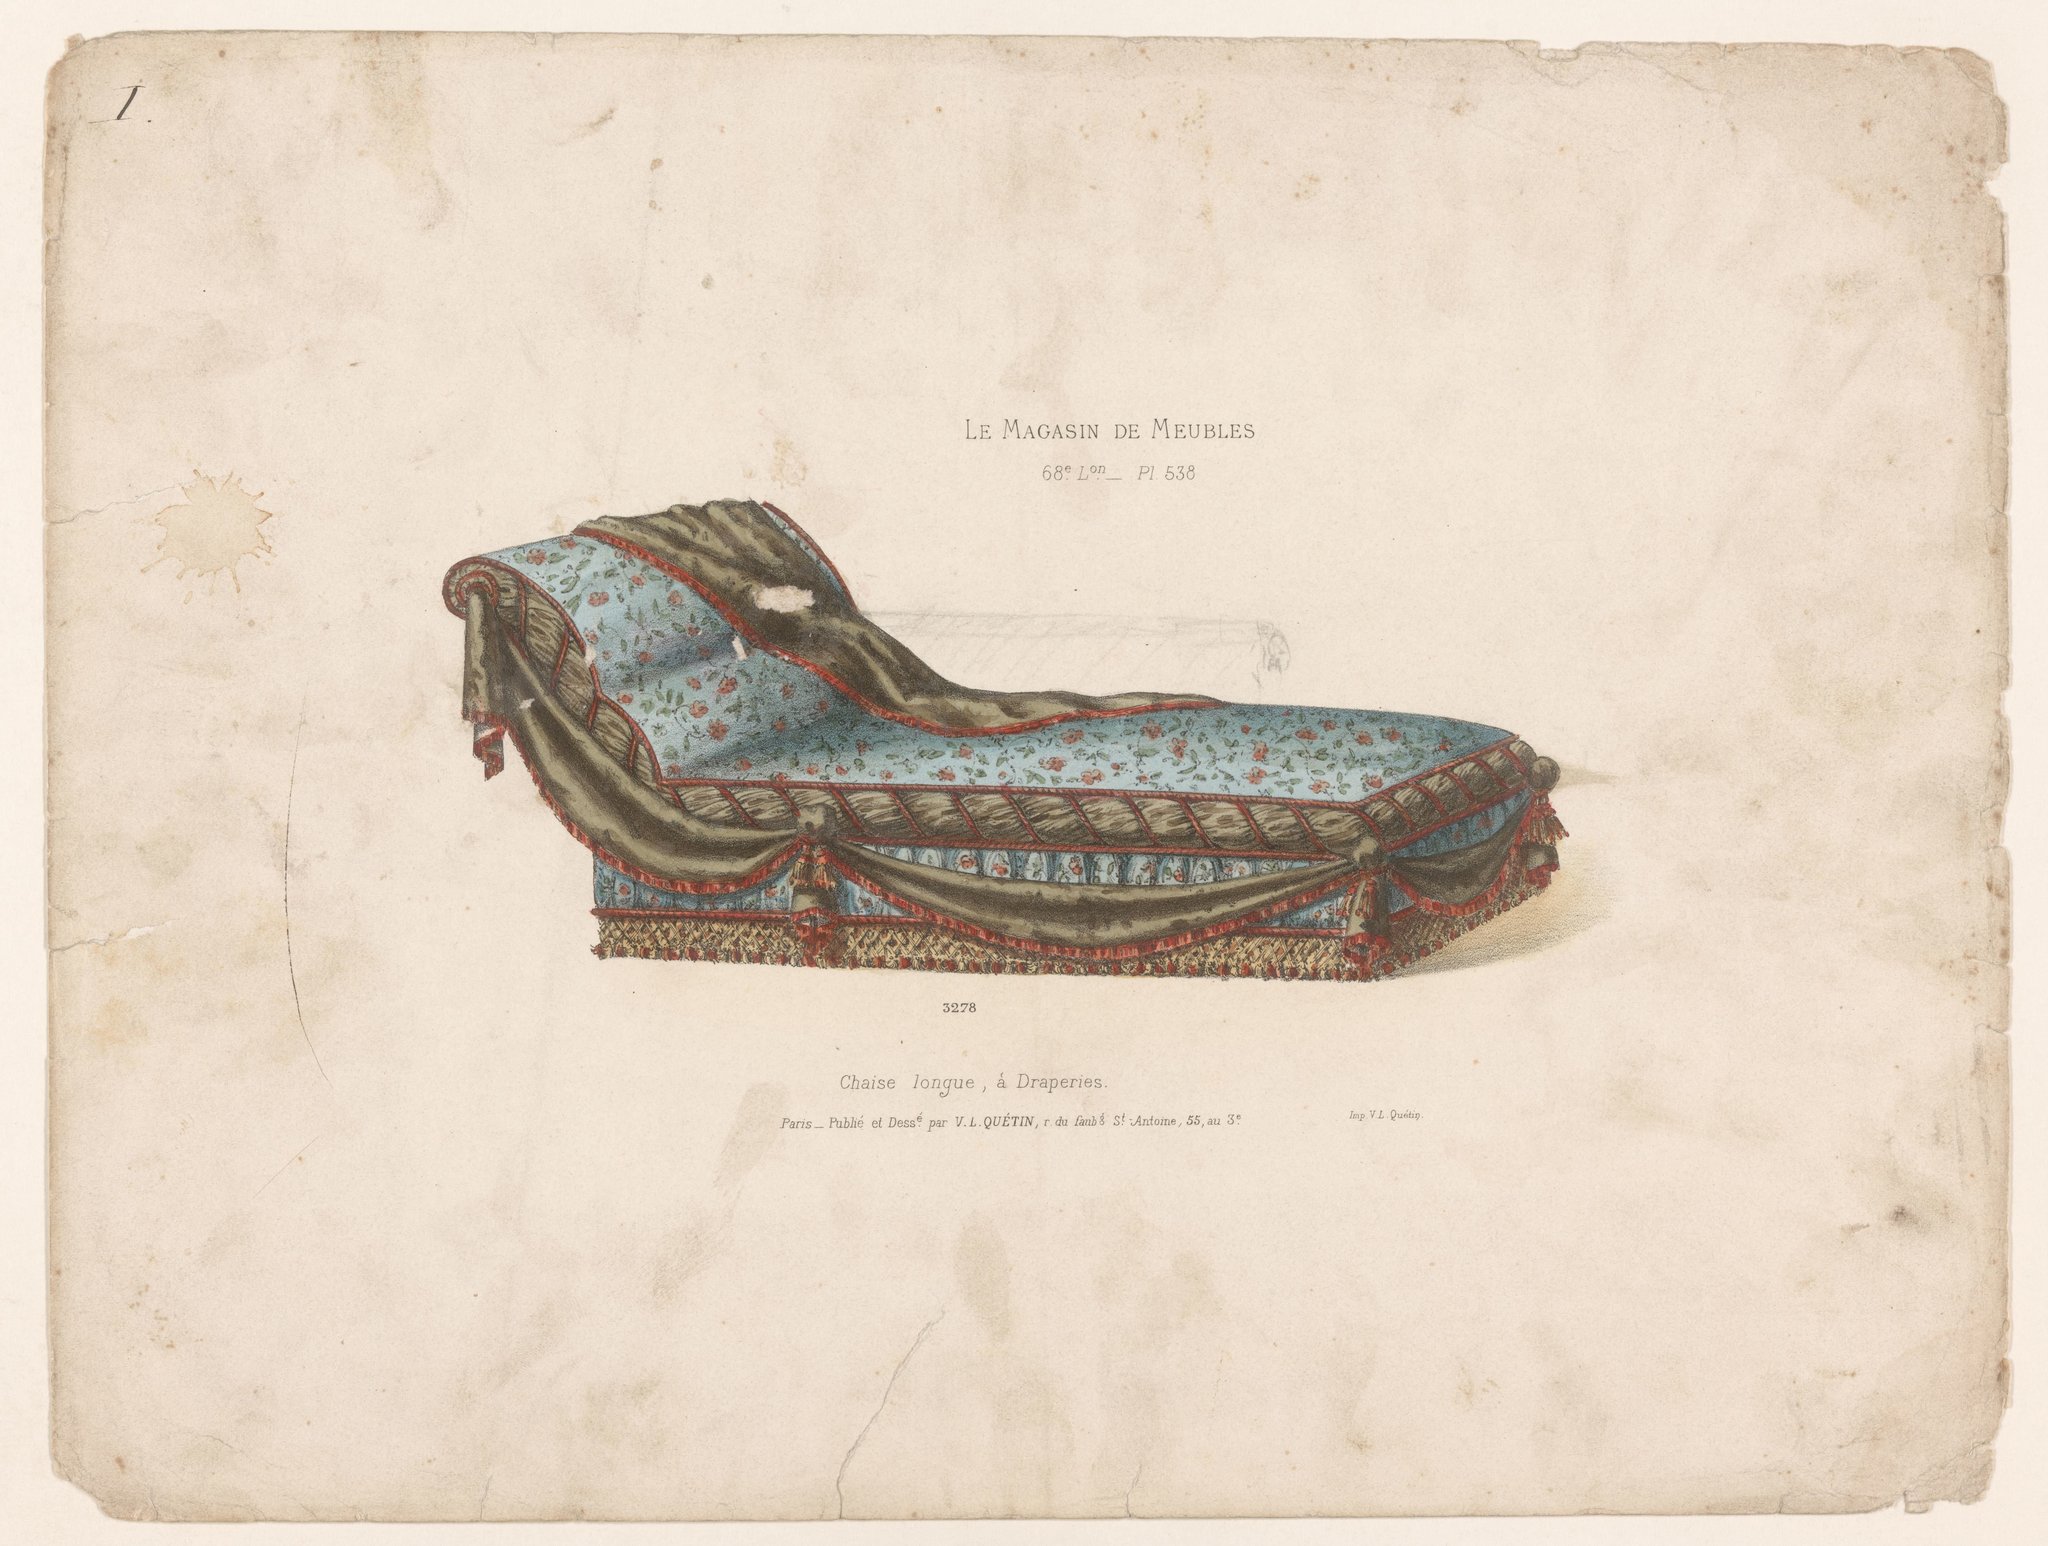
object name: print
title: Chaise longue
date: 1878-1904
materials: paper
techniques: hand coloring, lithograph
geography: paris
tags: seating furniture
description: Een chaise longue met draperieën. Prent uit 68e Livraison.